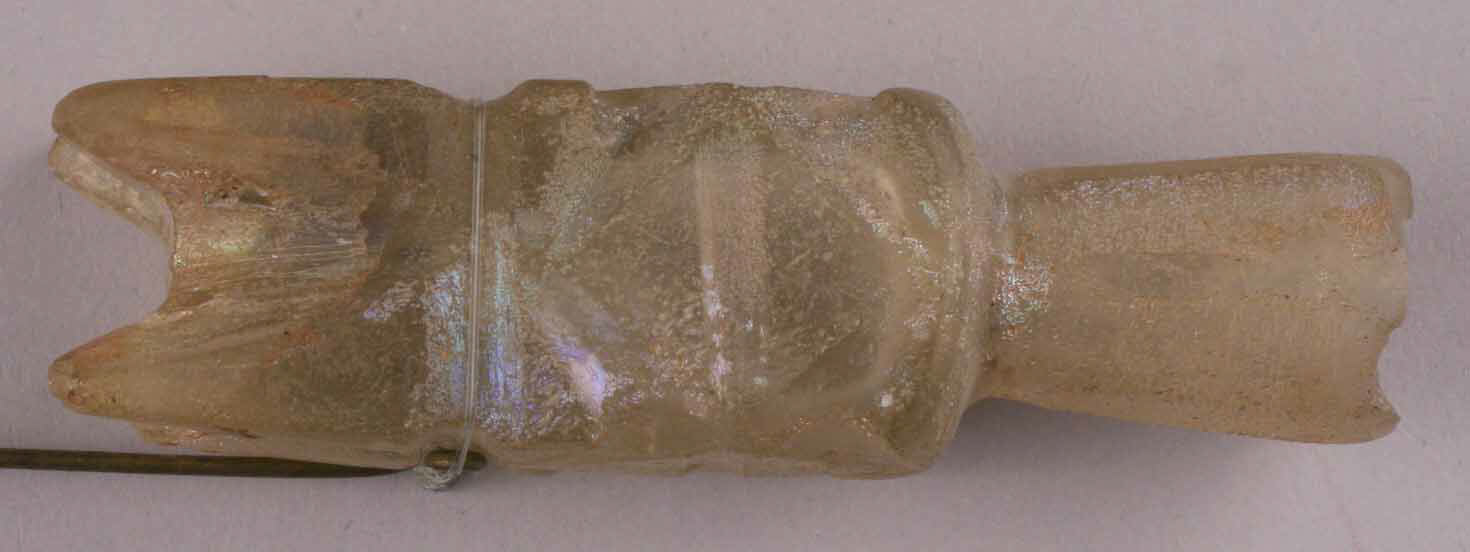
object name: bottle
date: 801-1000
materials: glass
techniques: glassblowing, casting, cutting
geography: iran